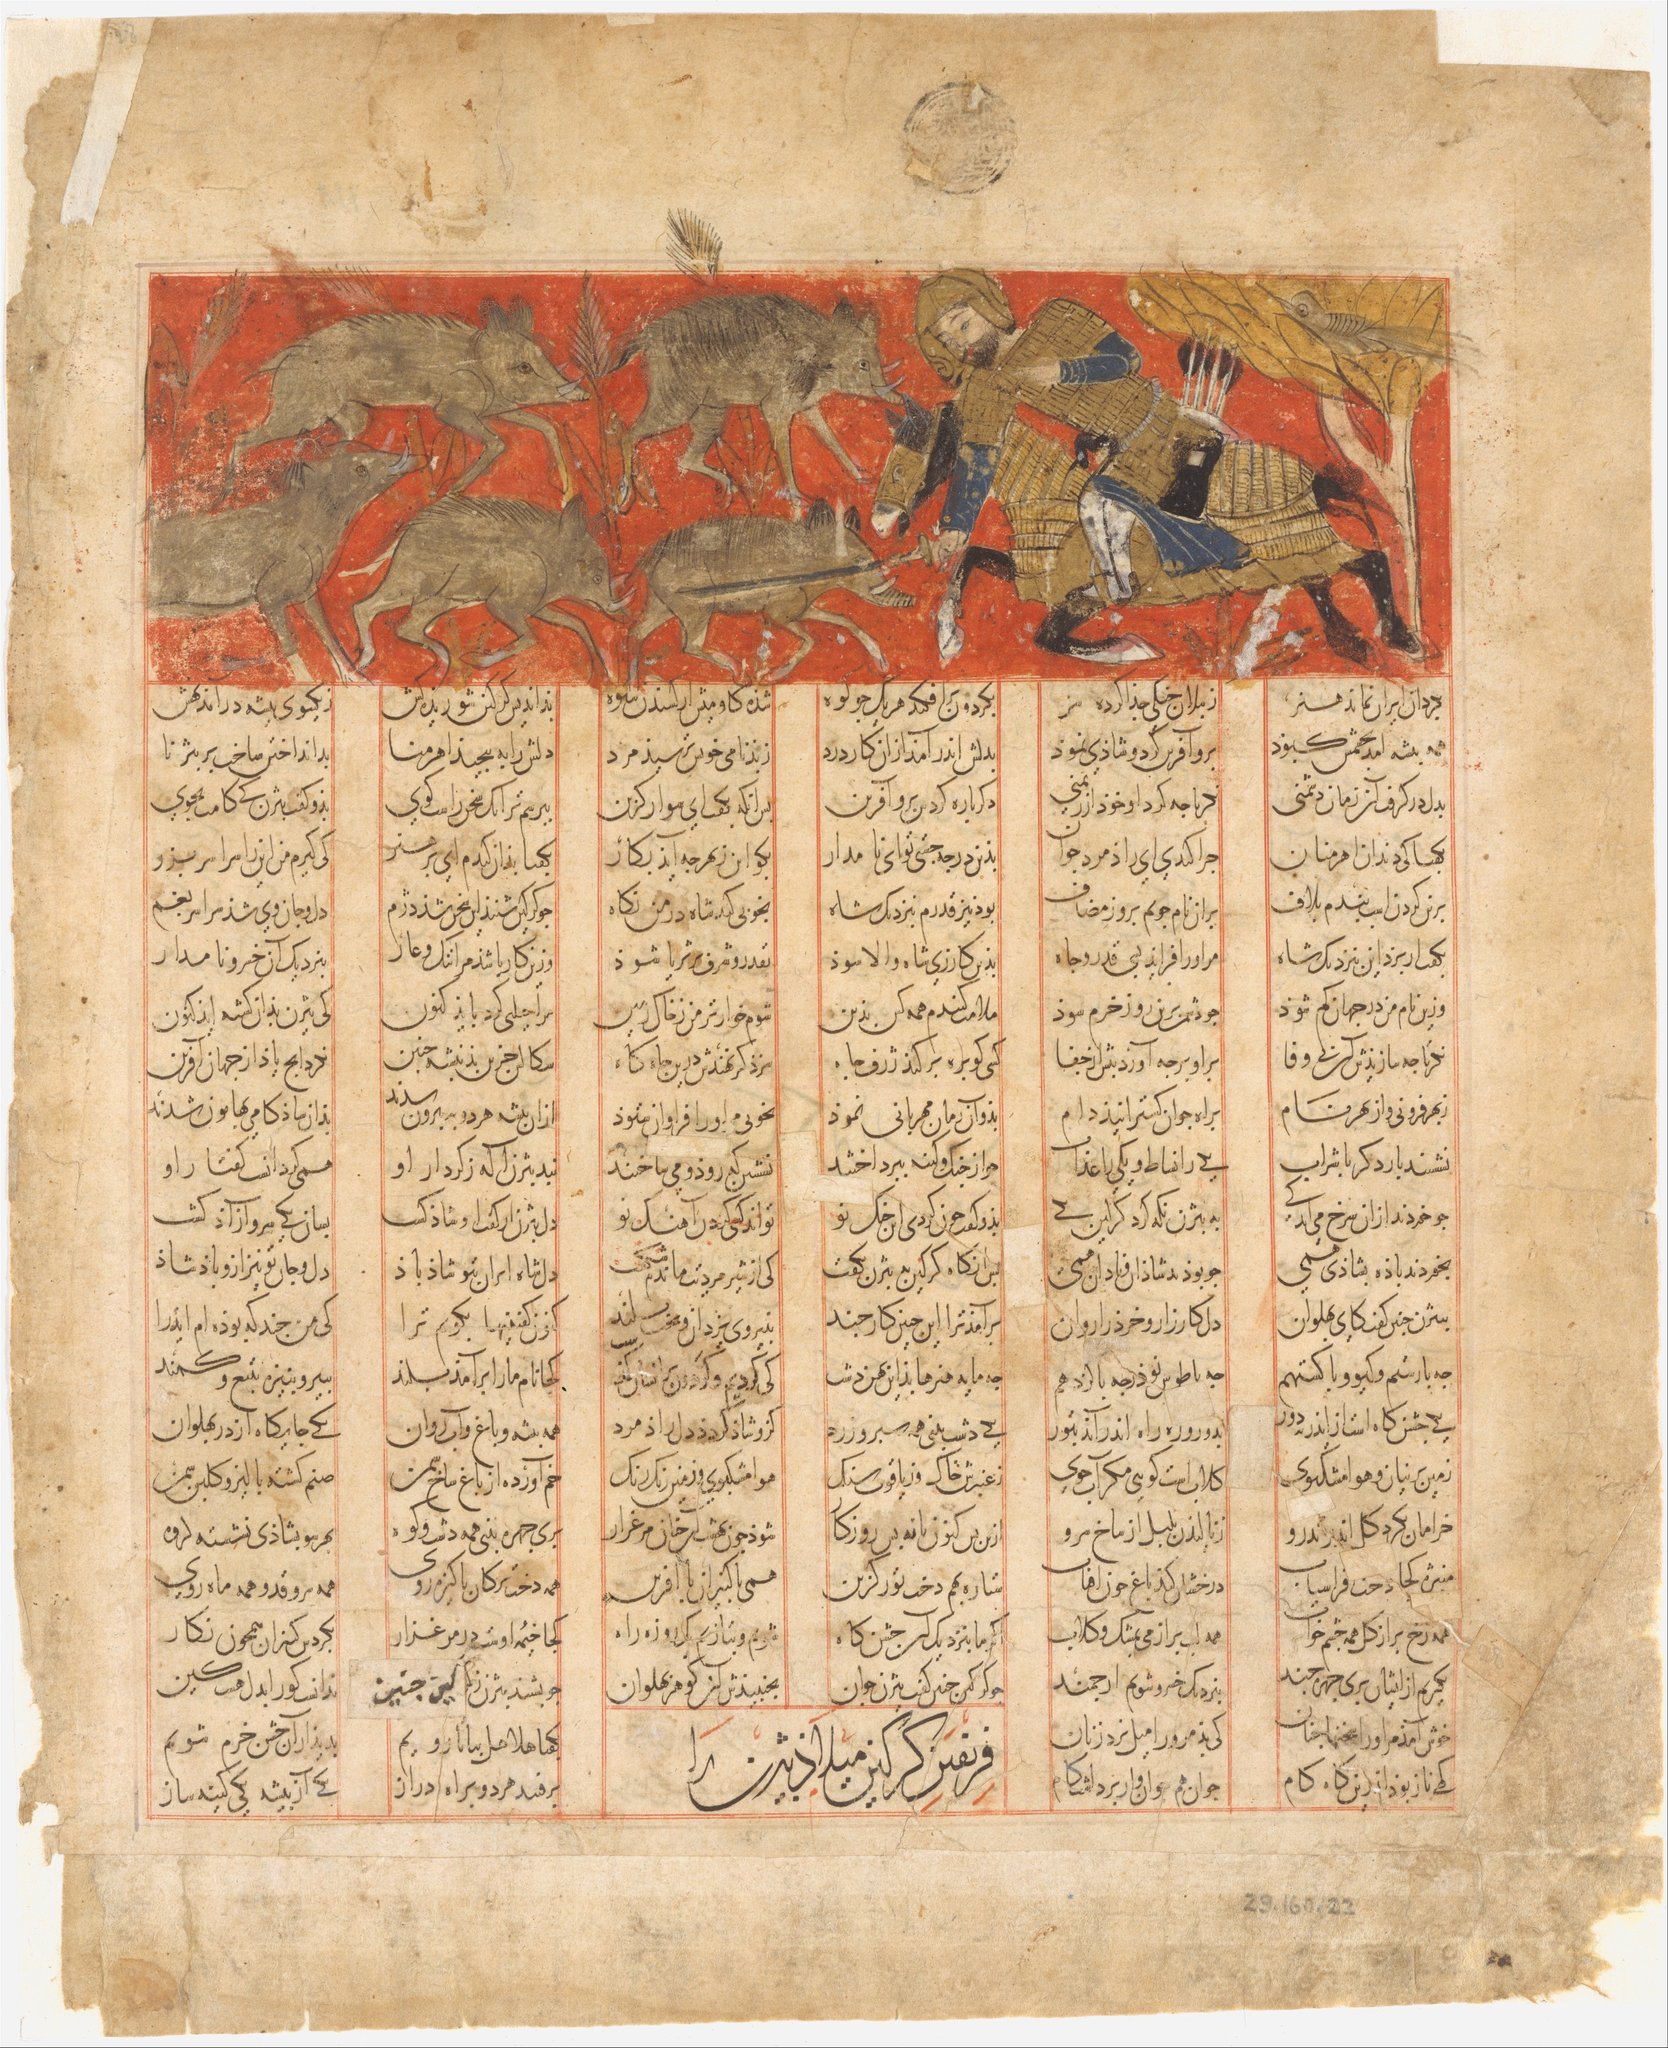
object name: folio from an illustrated manuscript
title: "Bizhan Slaughters the Wild Boars of Irman", Folio from a Shahnama (Book of Kings)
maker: abu'l qasim firdausi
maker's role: author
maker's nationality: iranian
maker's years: 935-1020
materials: gold, ink, paper, watercolor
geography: iran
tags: hunting,boars,horses